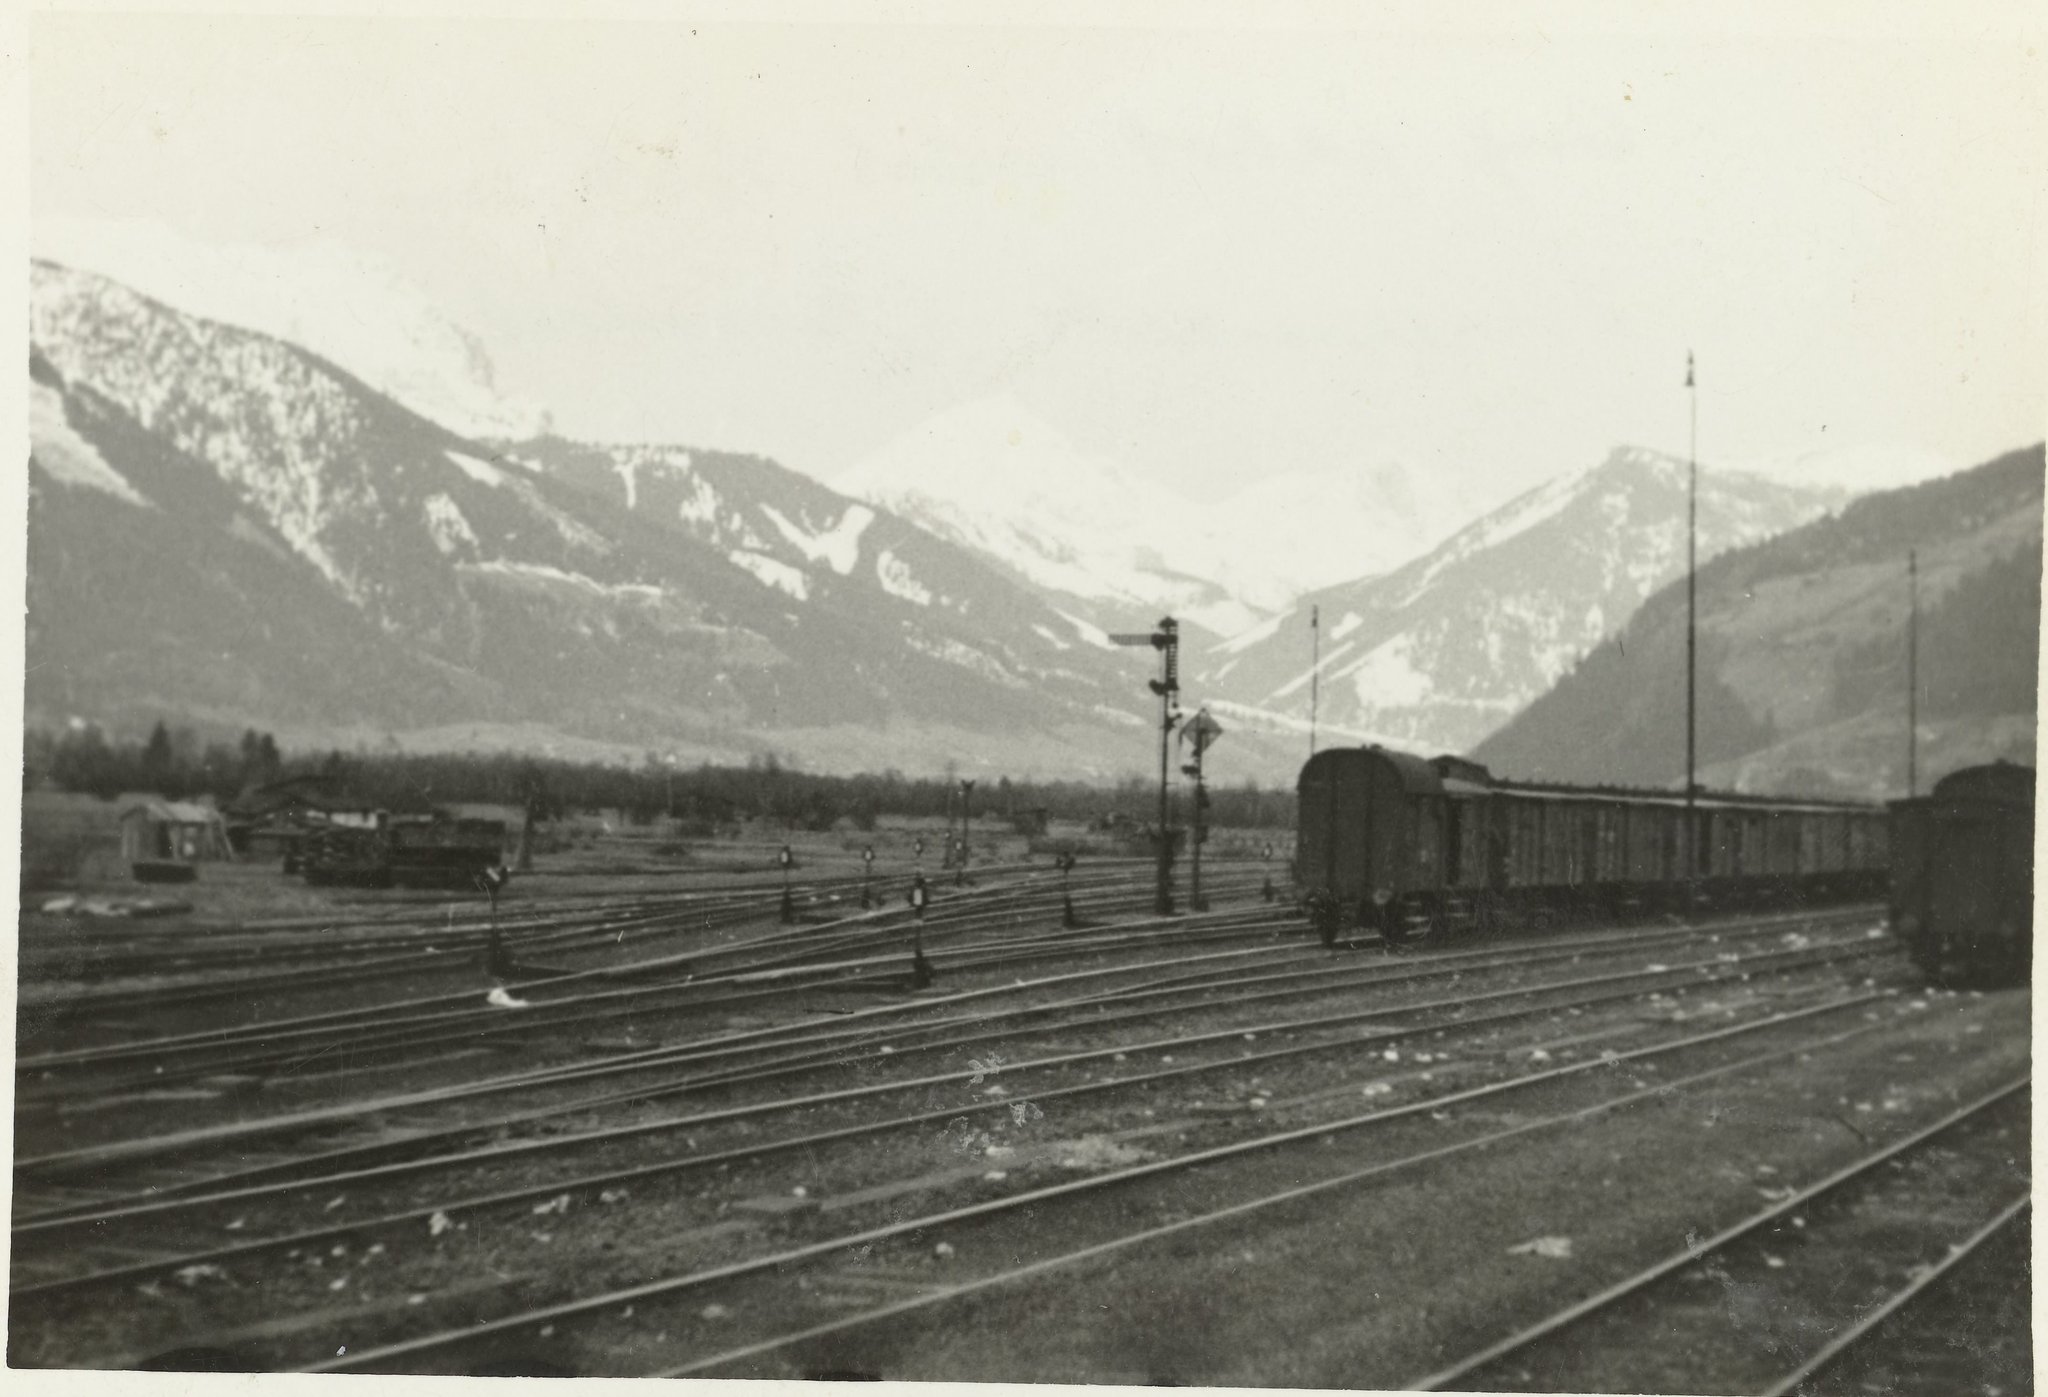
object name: photograph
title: Treinrailscomplex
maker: Anonymous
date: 1940-1945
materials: photographic support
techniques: gelatin silver print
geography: france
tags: netherlands, germany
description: Treinrailscomplex en treinen met bergen op de achtergrond. Opschrift: Auf Fahrt nach Serbien, Steiermark ( Emstal). Foto behorend bij album 'Kriegserinnerungen'.